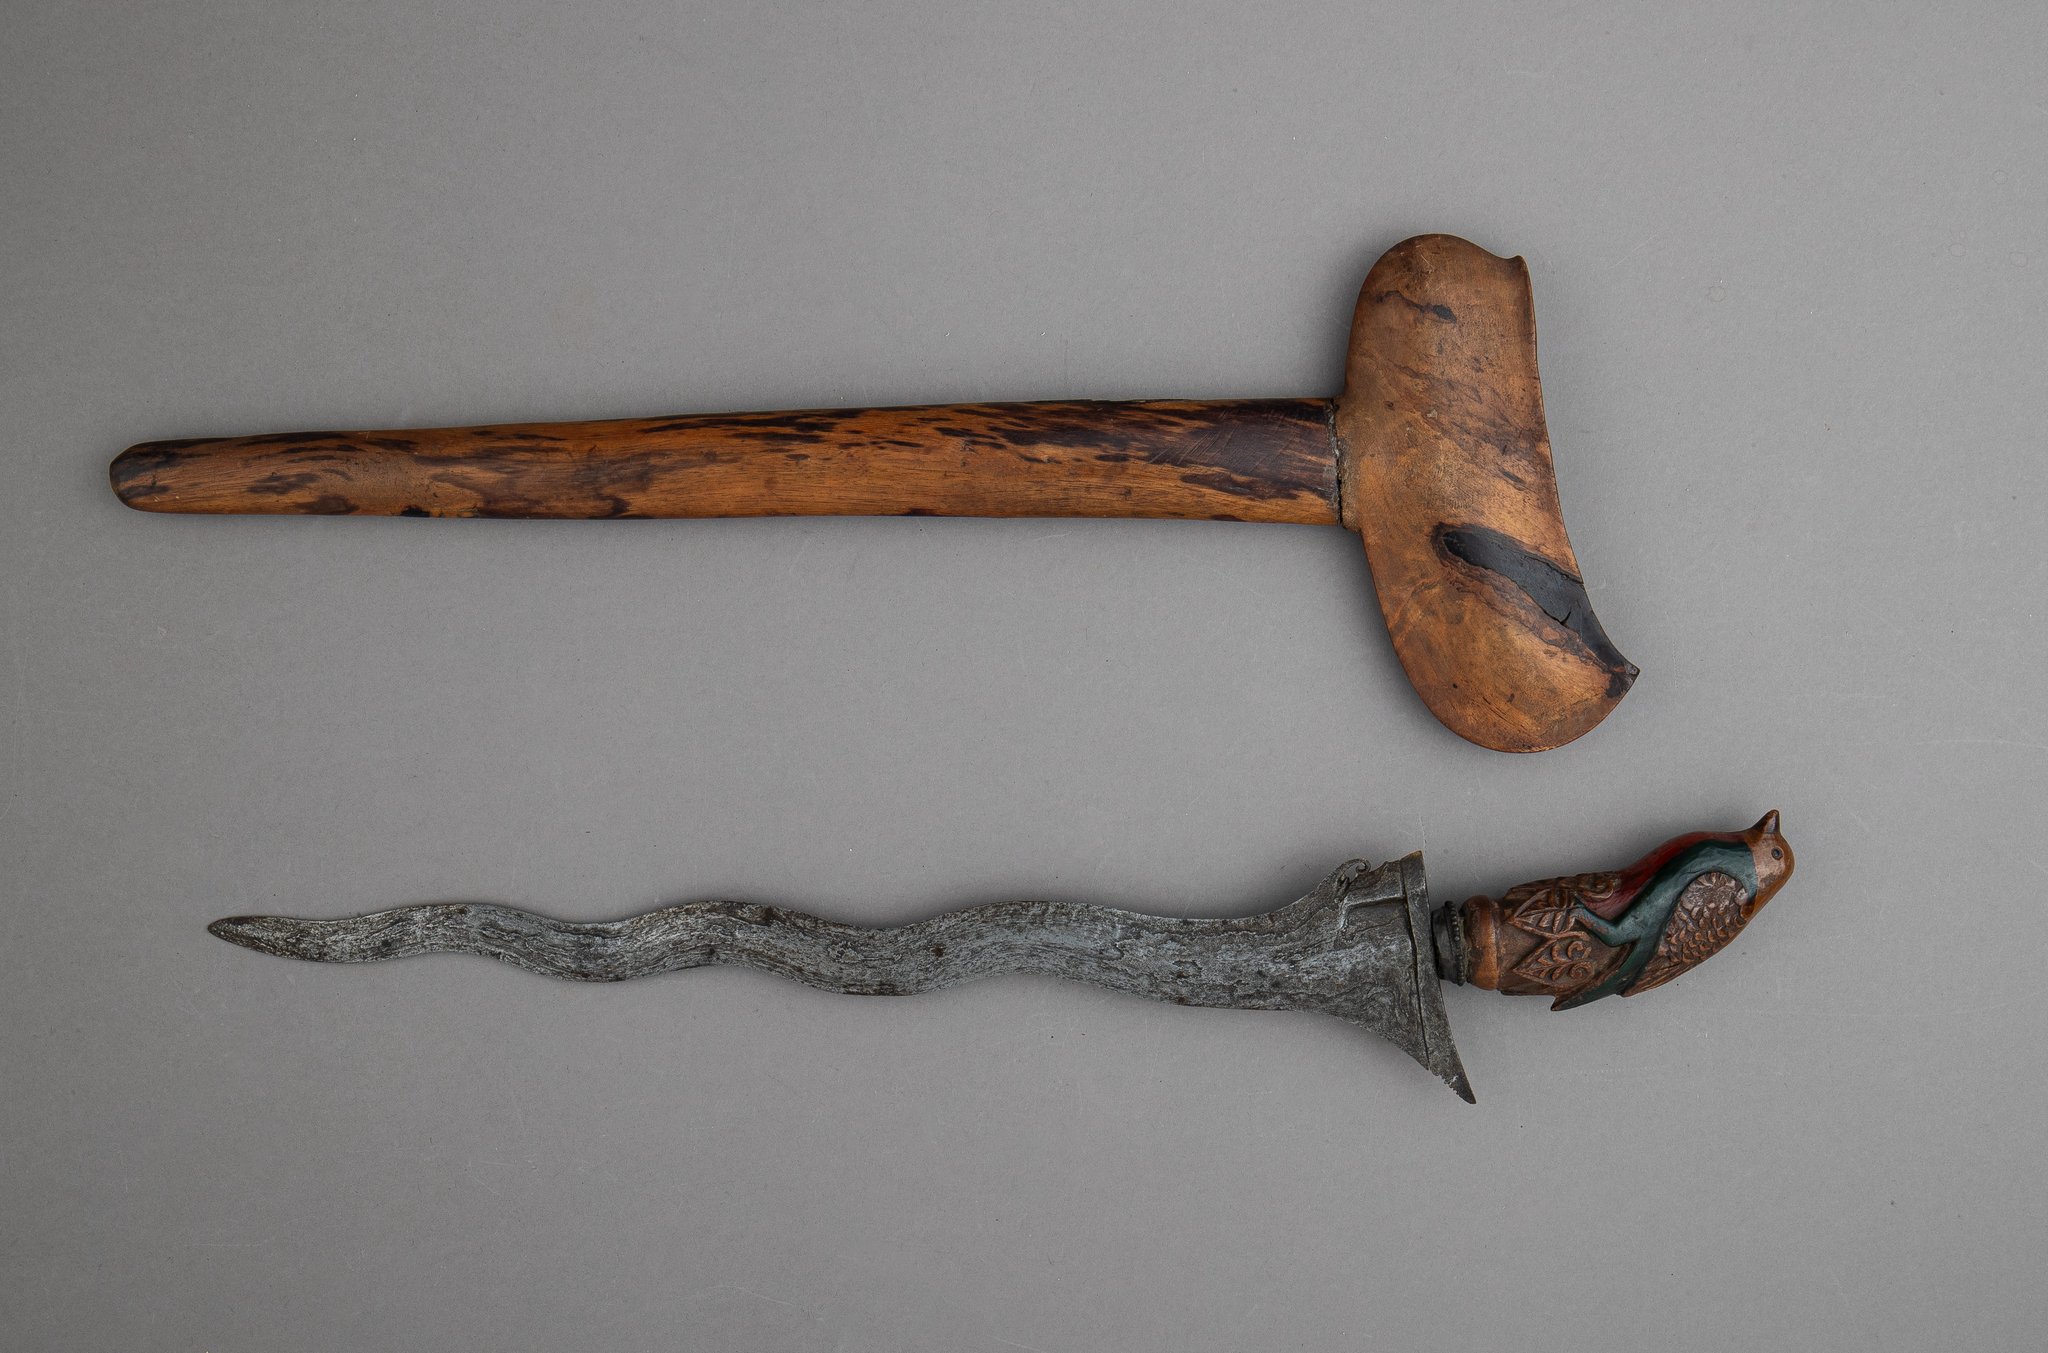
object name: kris with sheath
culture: javanese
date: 1501-1900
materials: steel, wood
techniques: polychromy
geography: indonesia